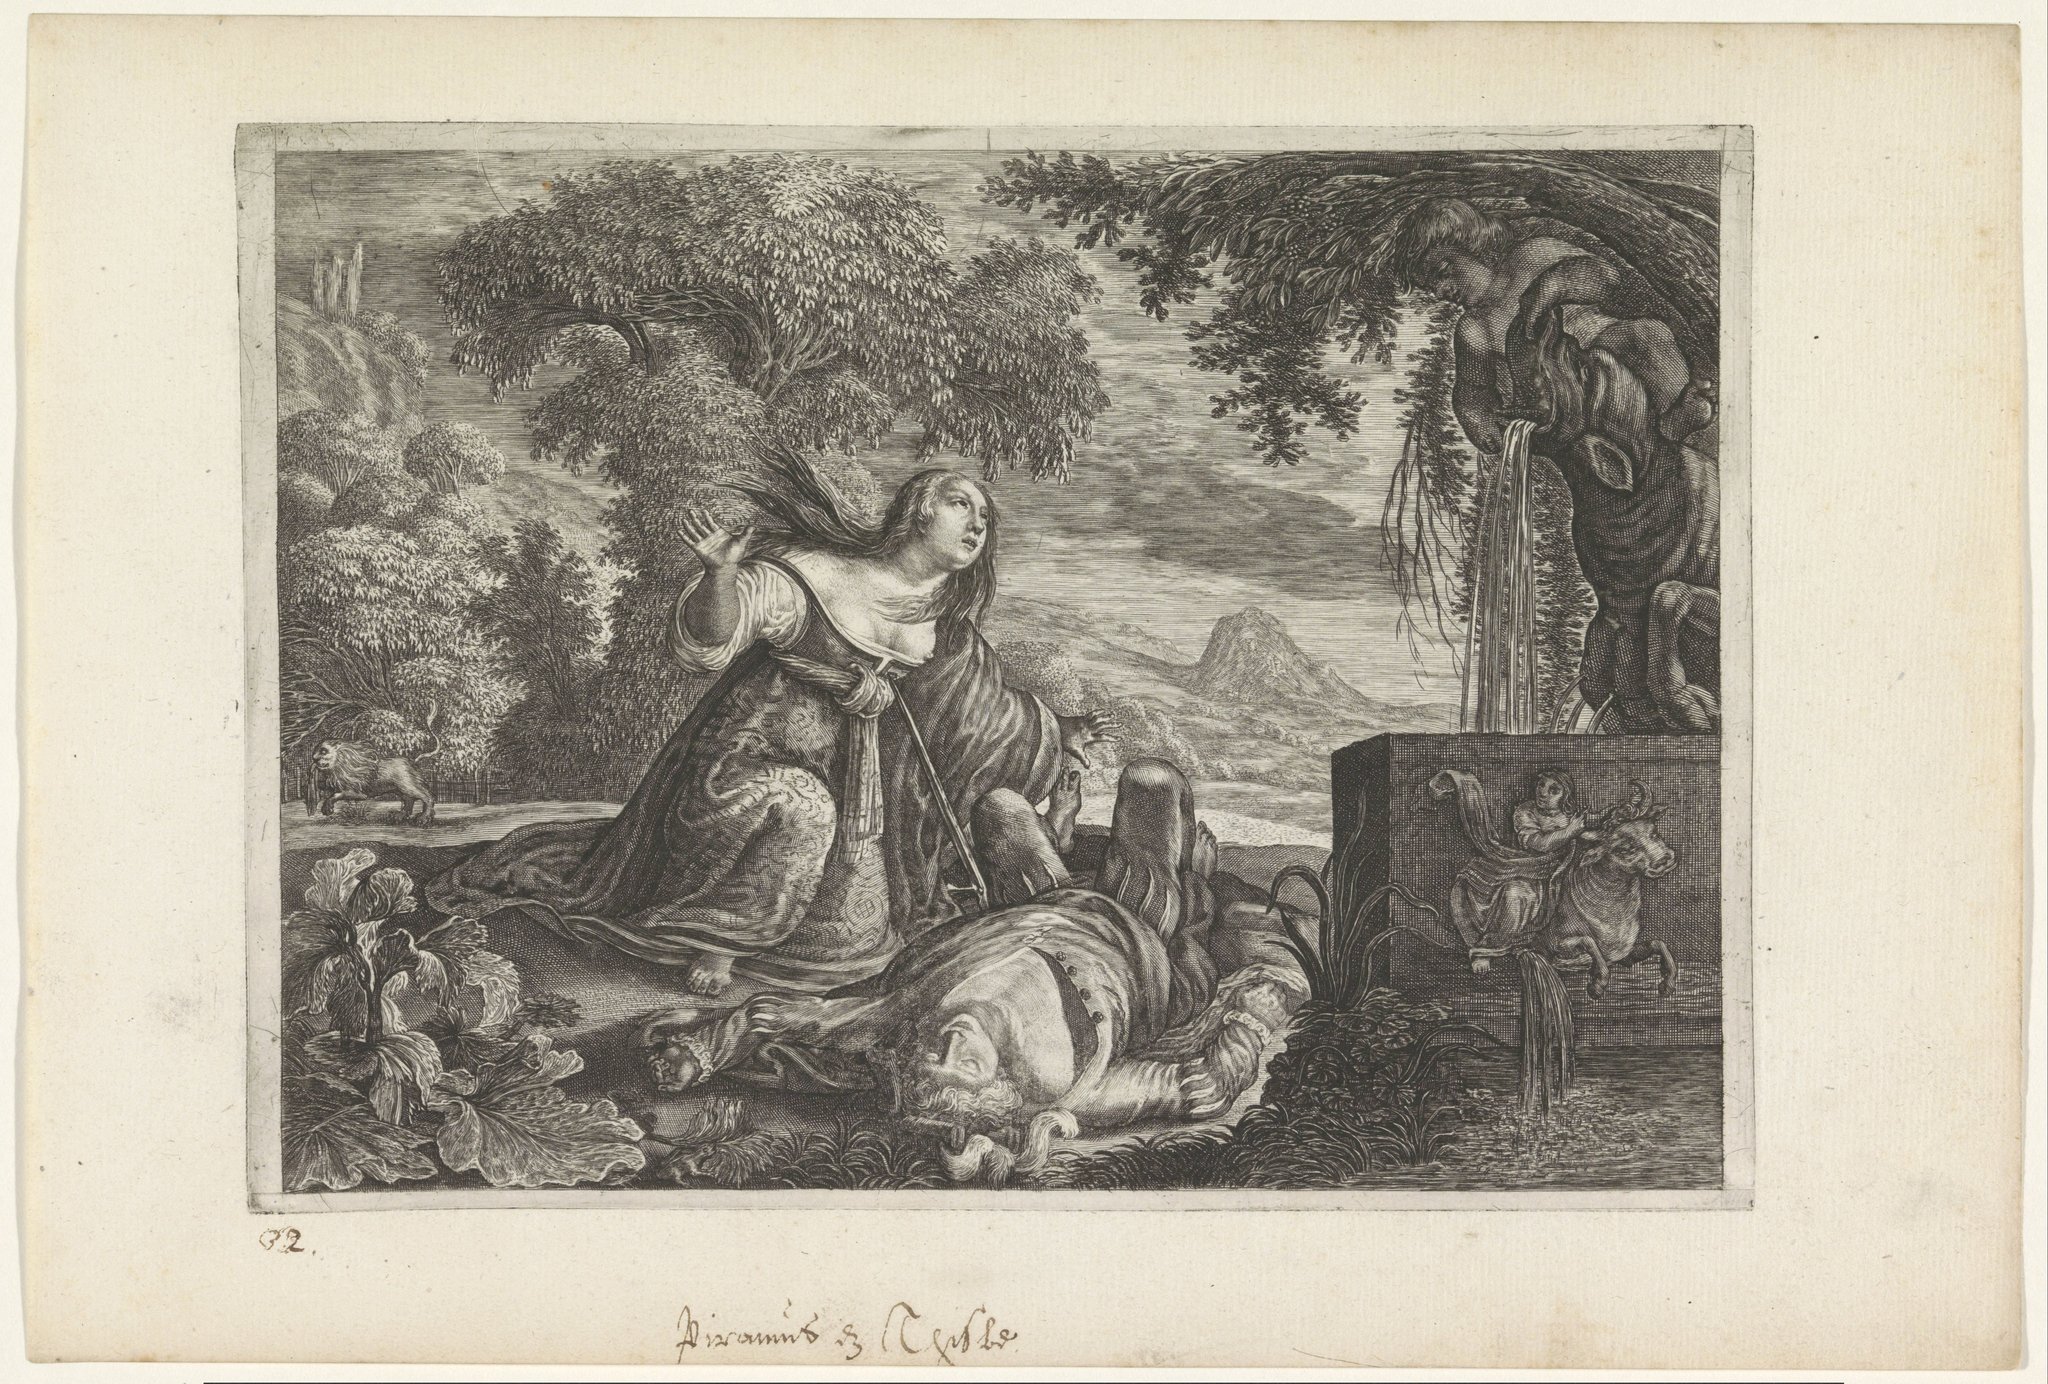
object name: print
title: Pyramus and Thisbe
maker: magdalena van de passe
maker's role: print maker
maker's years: 1600-1638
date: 1636-1670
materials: paper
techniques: engraving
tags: thisbe kills herself with pyramus' sword (the scene may be represented near a fountain)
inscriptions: collector's mark: ‘Hinloopen’, annotation: ‘Piramus en Thisbe’, number: ‘32’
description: The myths depicted here are of two ill-fated love affairs. Adonis, the lover of the goddess Venus, was attacked by a boar while hunting. Pyramus lashed out when he thought his beloved Thisbe had been killed by a lion. Magdalena de Passe depicted the grief of the lovers left behind with a sense of drama. Adonis’ hound also weeps.